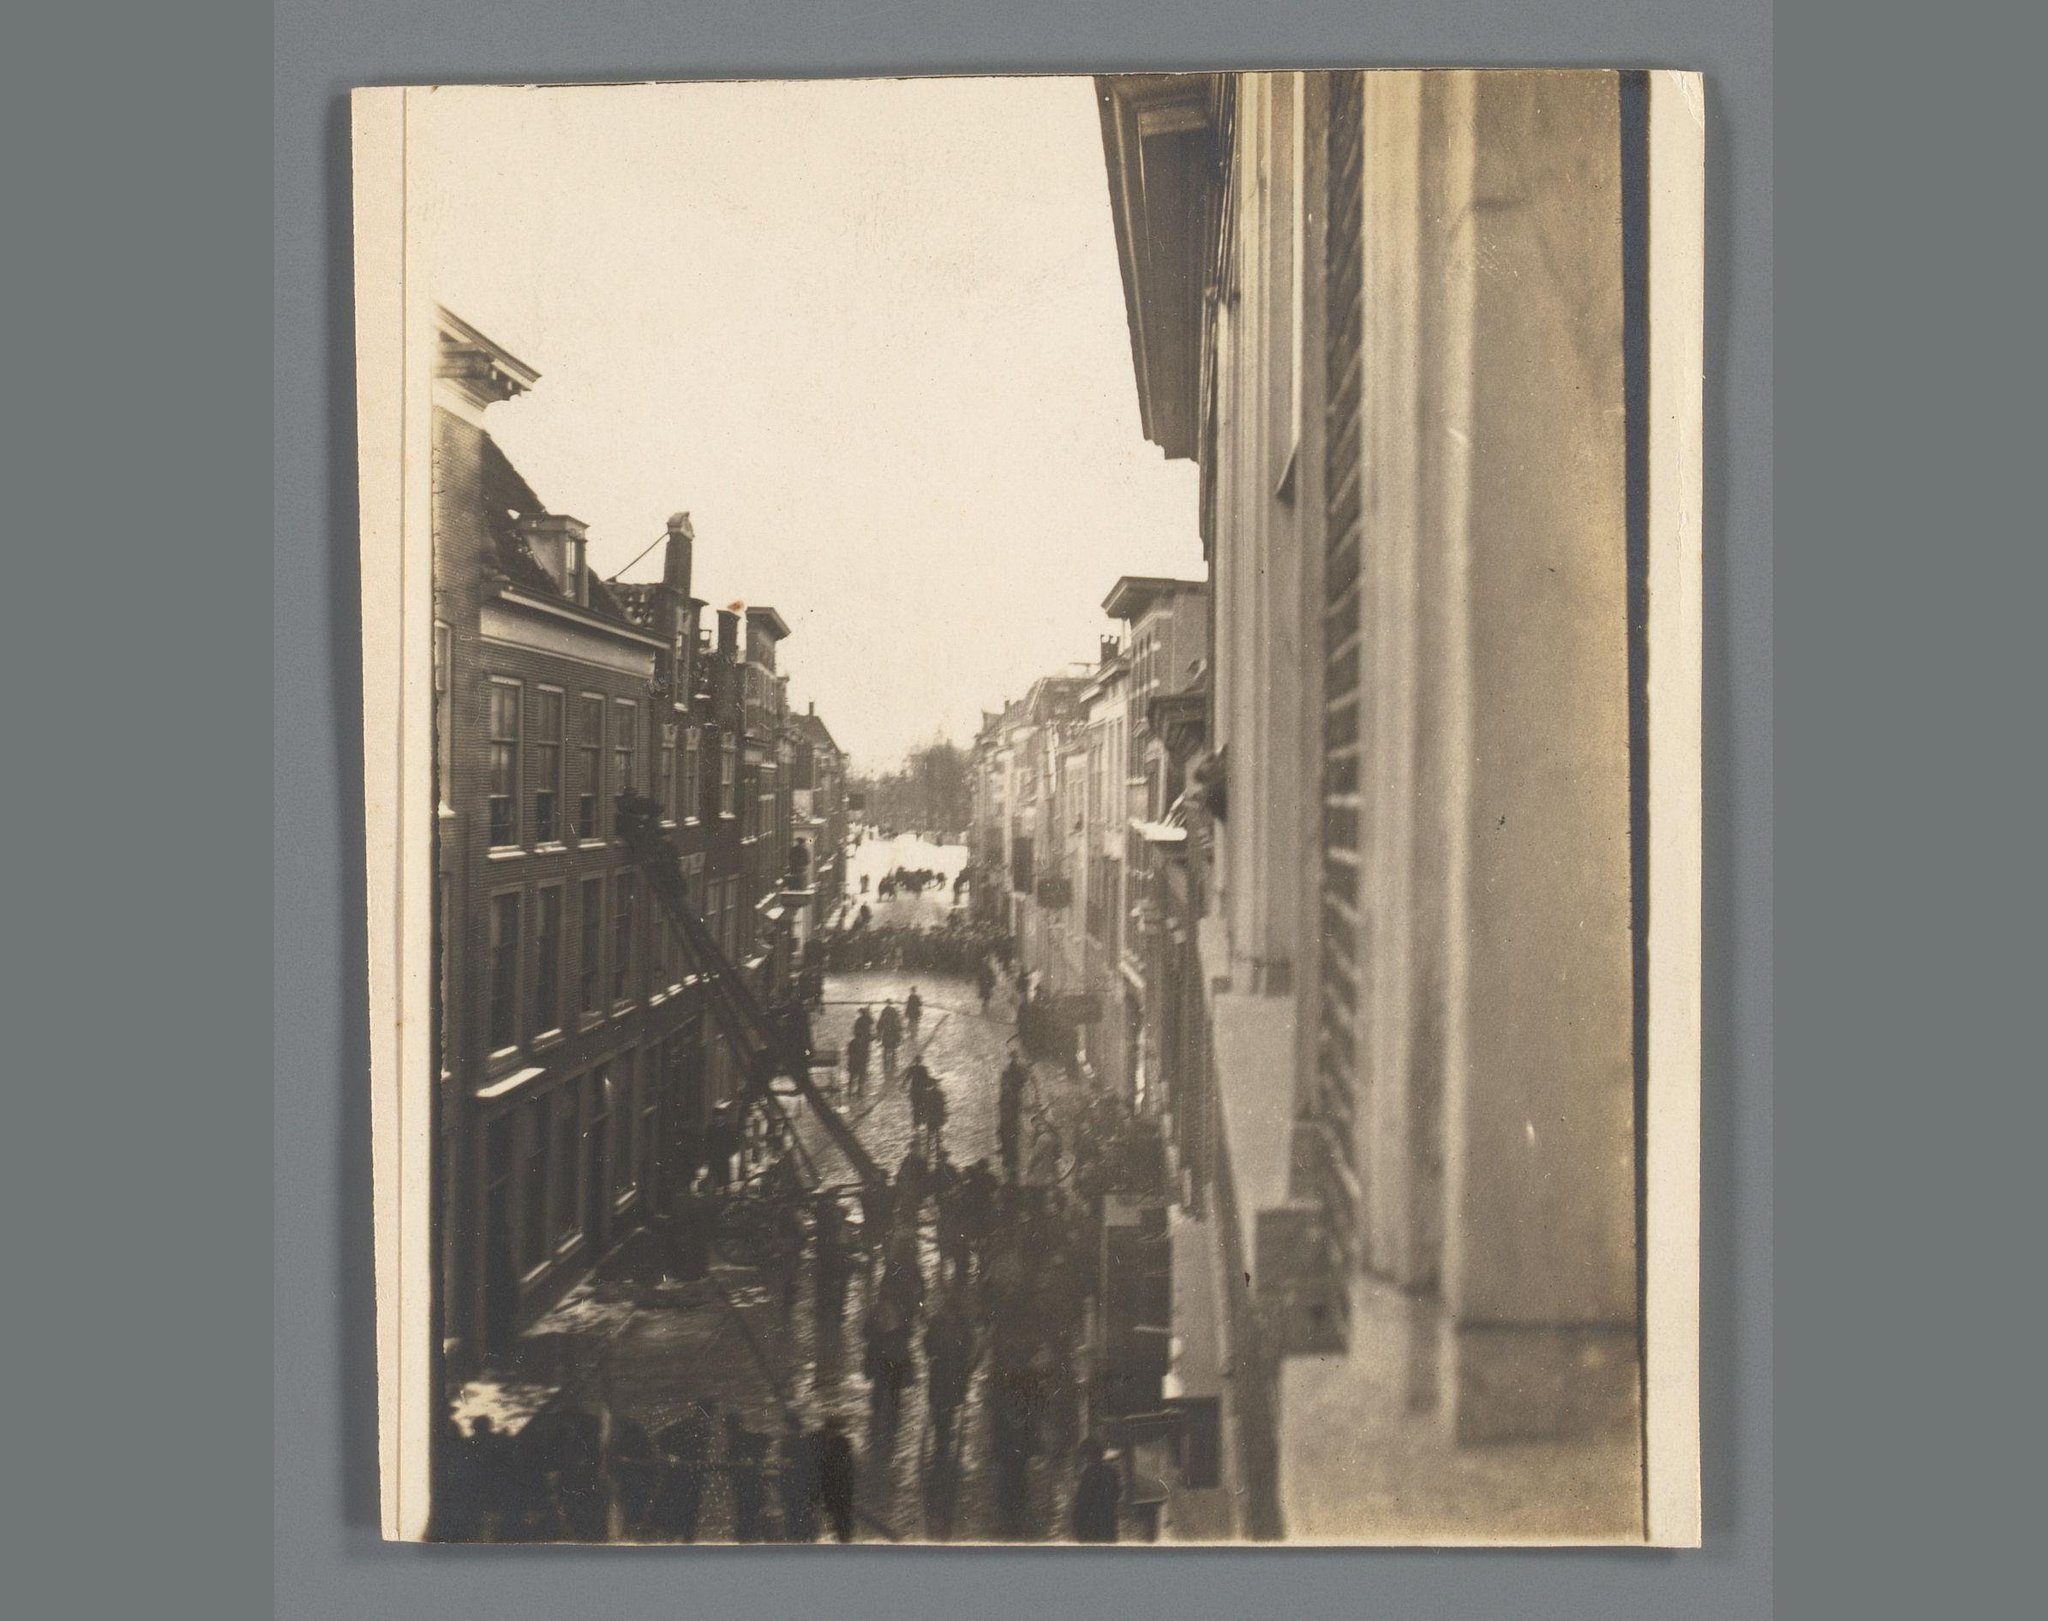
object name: photograph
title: Menigte bij brand in een woning aan het Noordeinde, Leiden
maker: willem de jong (fotograaf)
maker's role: arts, fotograaf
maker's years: 1864-1918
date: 1895-1918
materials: paper, cardboard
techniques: gelatin silver print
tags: crowd, mob, fire-department, fire-brigade, street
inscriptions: inscription: ‘Dr. W. DE JONG./ Arts./ Leiden,...(...)190’, inscription: ‘23/ brand in Noordeinde/ L.B.’